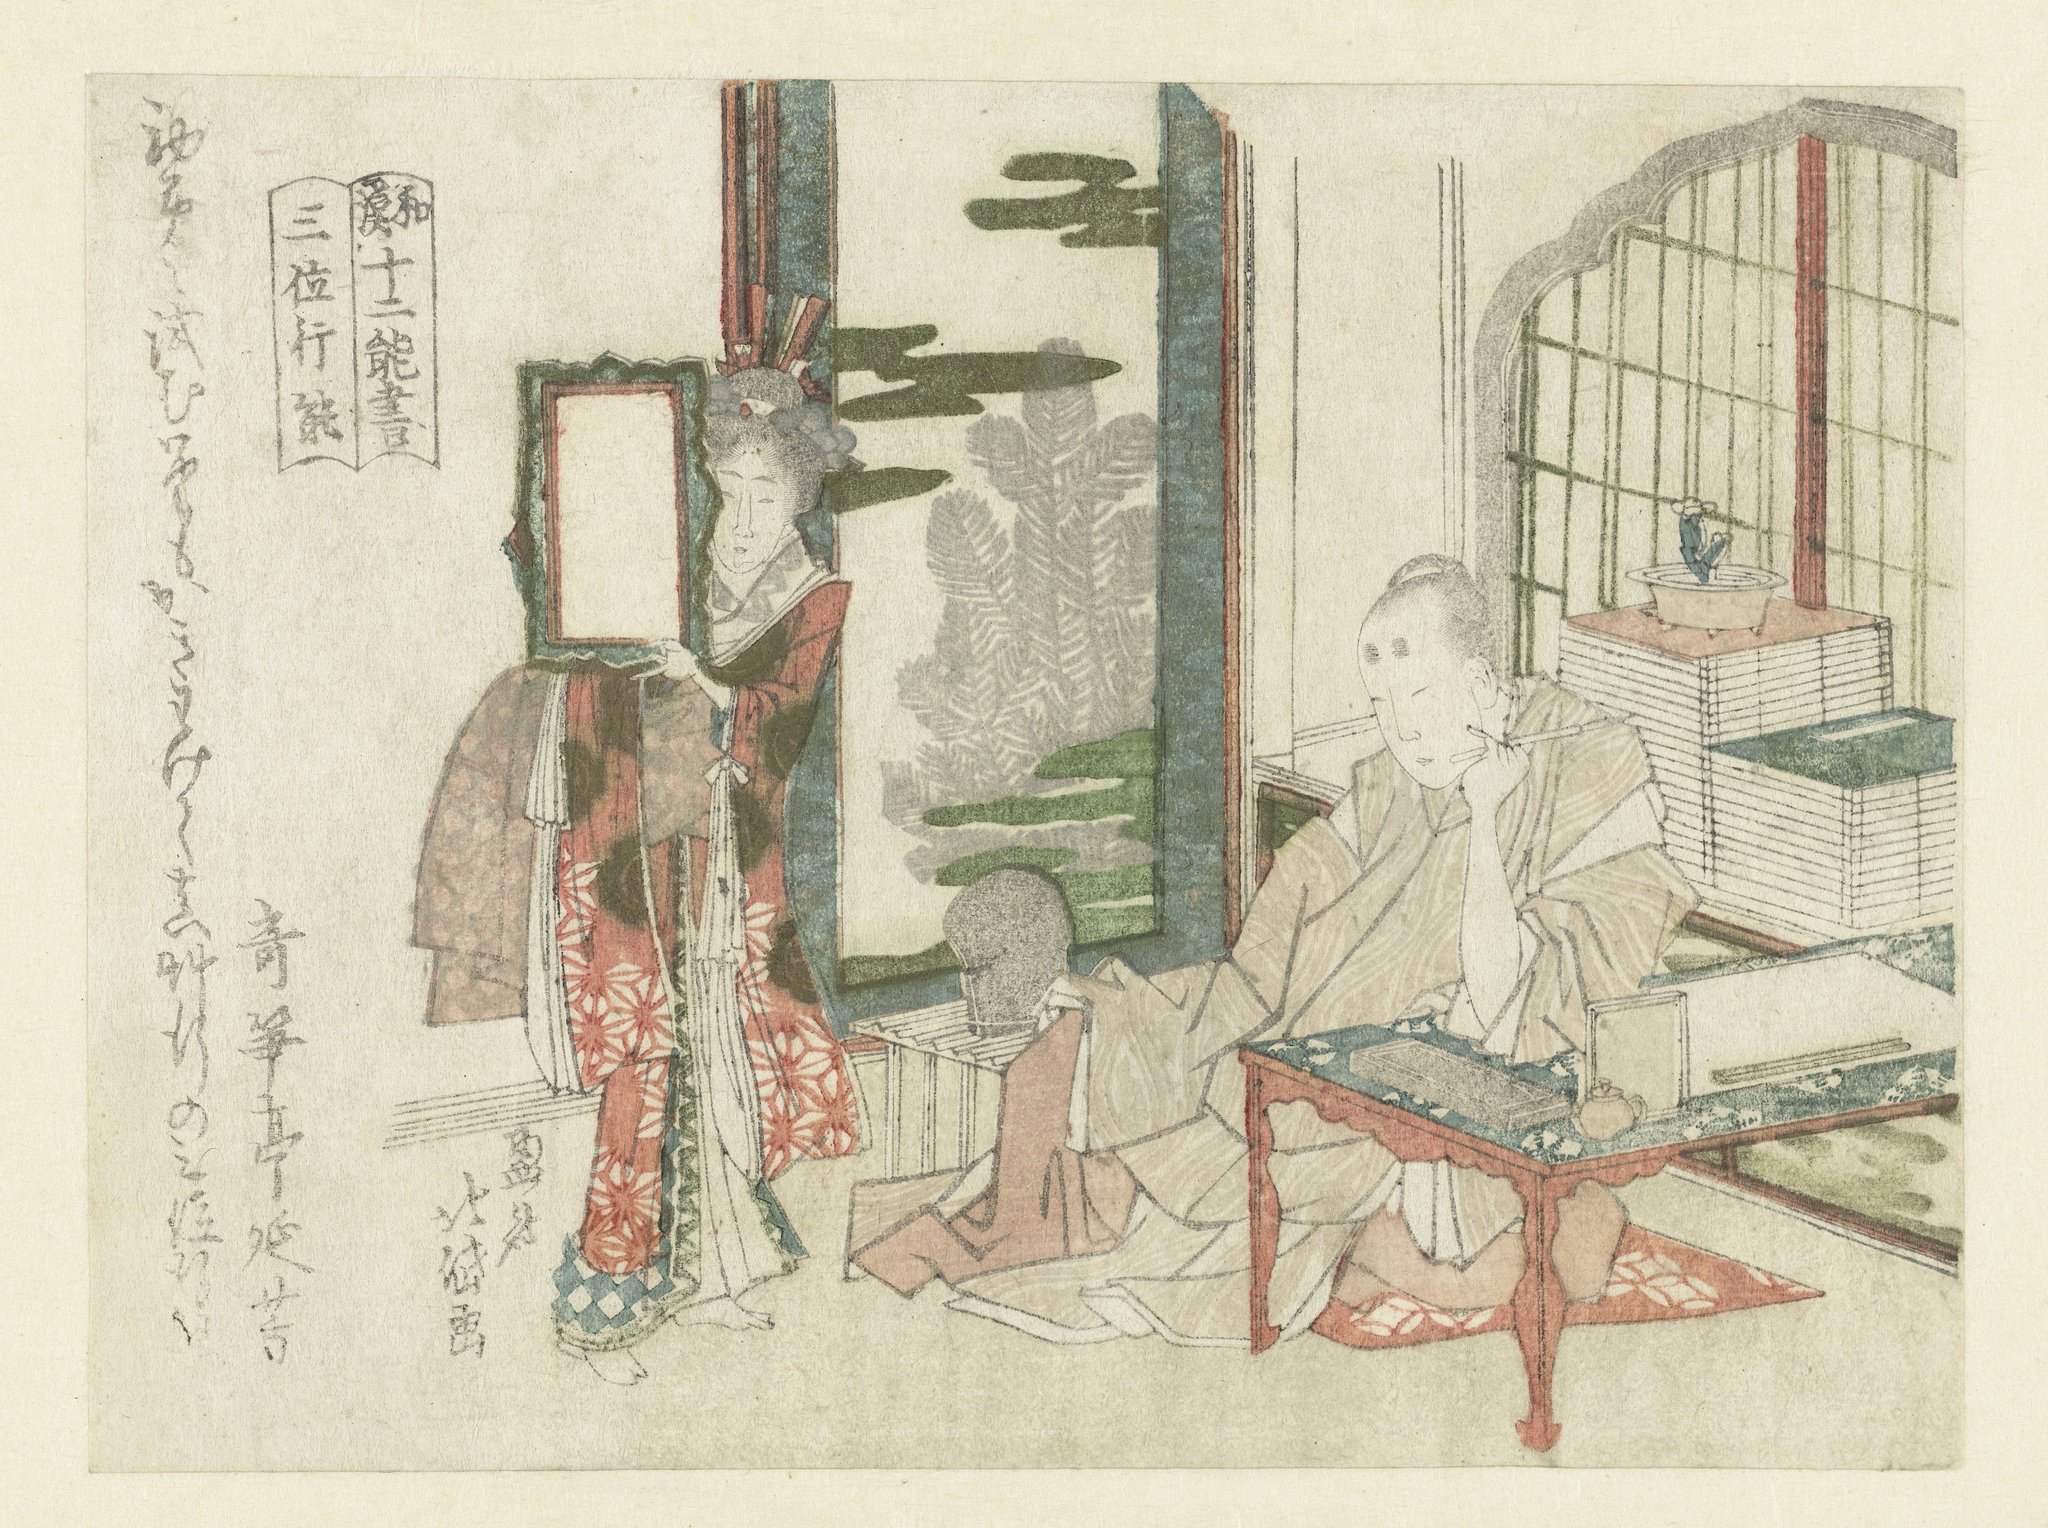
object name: print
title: A Man Seated at a Writing Table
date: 1806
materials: paper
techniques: woodcut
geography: japan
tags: mirror, calligraphy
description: Een surimono is een luxe uitgevoerde prent waarop beeld met één of meerdere gedichten gecombineerd is. Bij het drukken van een surimono werd vaak gebruik gemaakt van dikker papier, blinddruk en metaal pigmenten, zoals koper- en zilverpoeder. De prenten werden vaak in opdracht van dichters gemaakt en als exclusief geschenk aan vrienden en relaties gegeven.